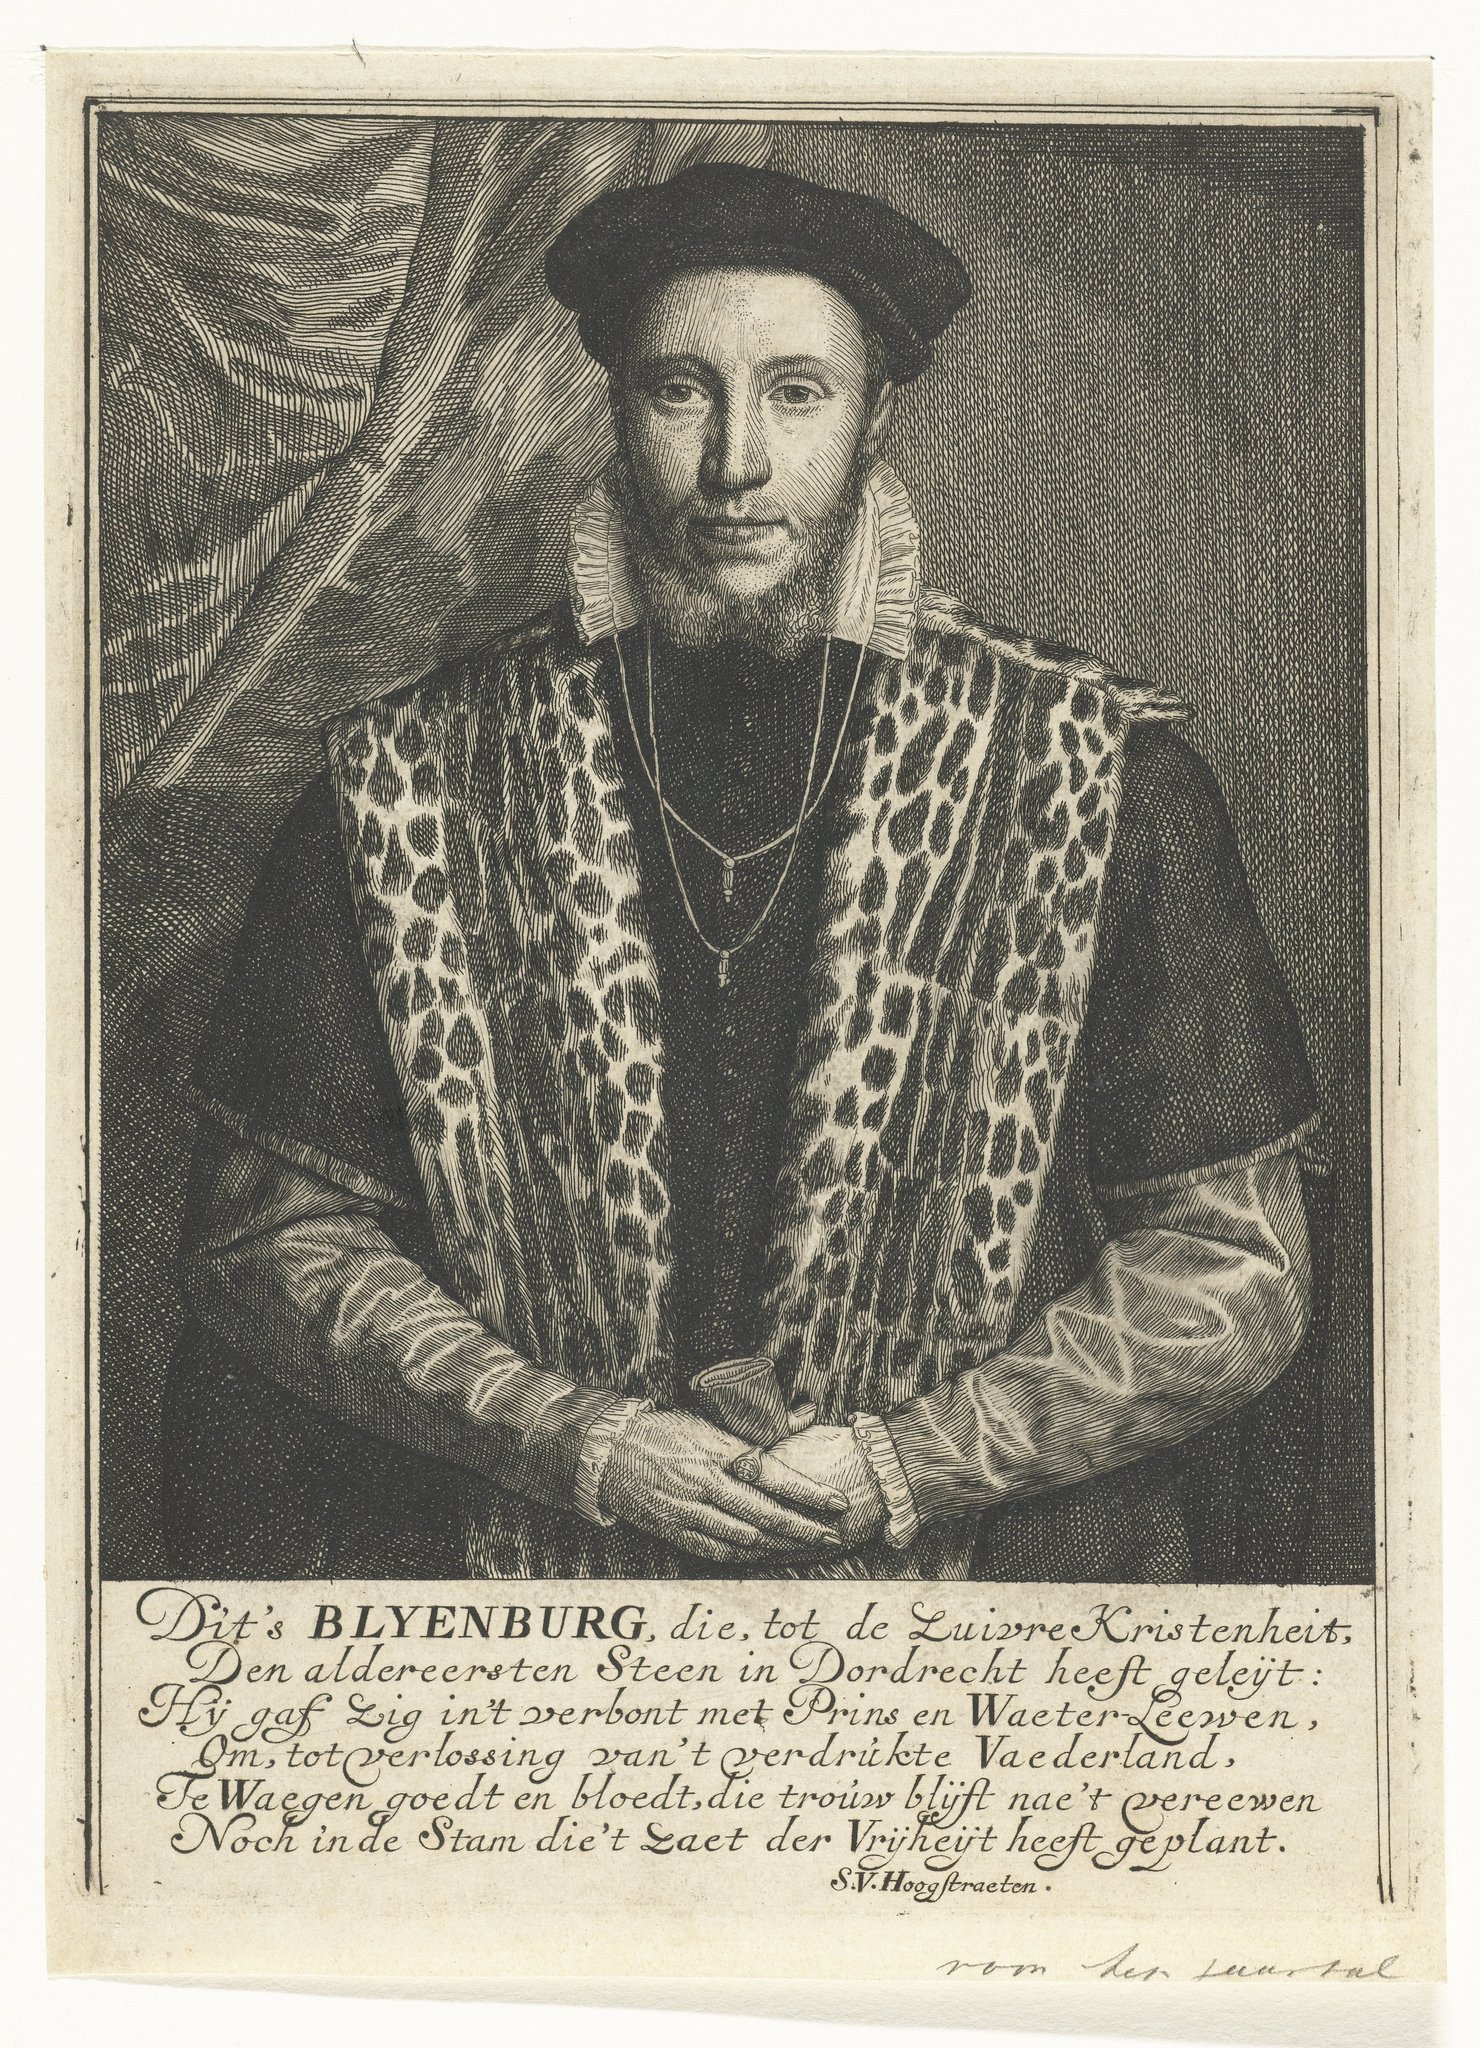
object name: print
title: Blyenburg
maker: samuel van hoogstraten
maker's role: draughtsman, painter, print maker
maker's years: 1627-1678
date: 1648-1677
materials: paper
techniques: etching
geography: netherlands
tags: historical persons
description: Adriaen van Blijenburgh, schout van Dordrecht, ten halven lijve. Onder het portret een zesregelige tekst in het Nederlands.